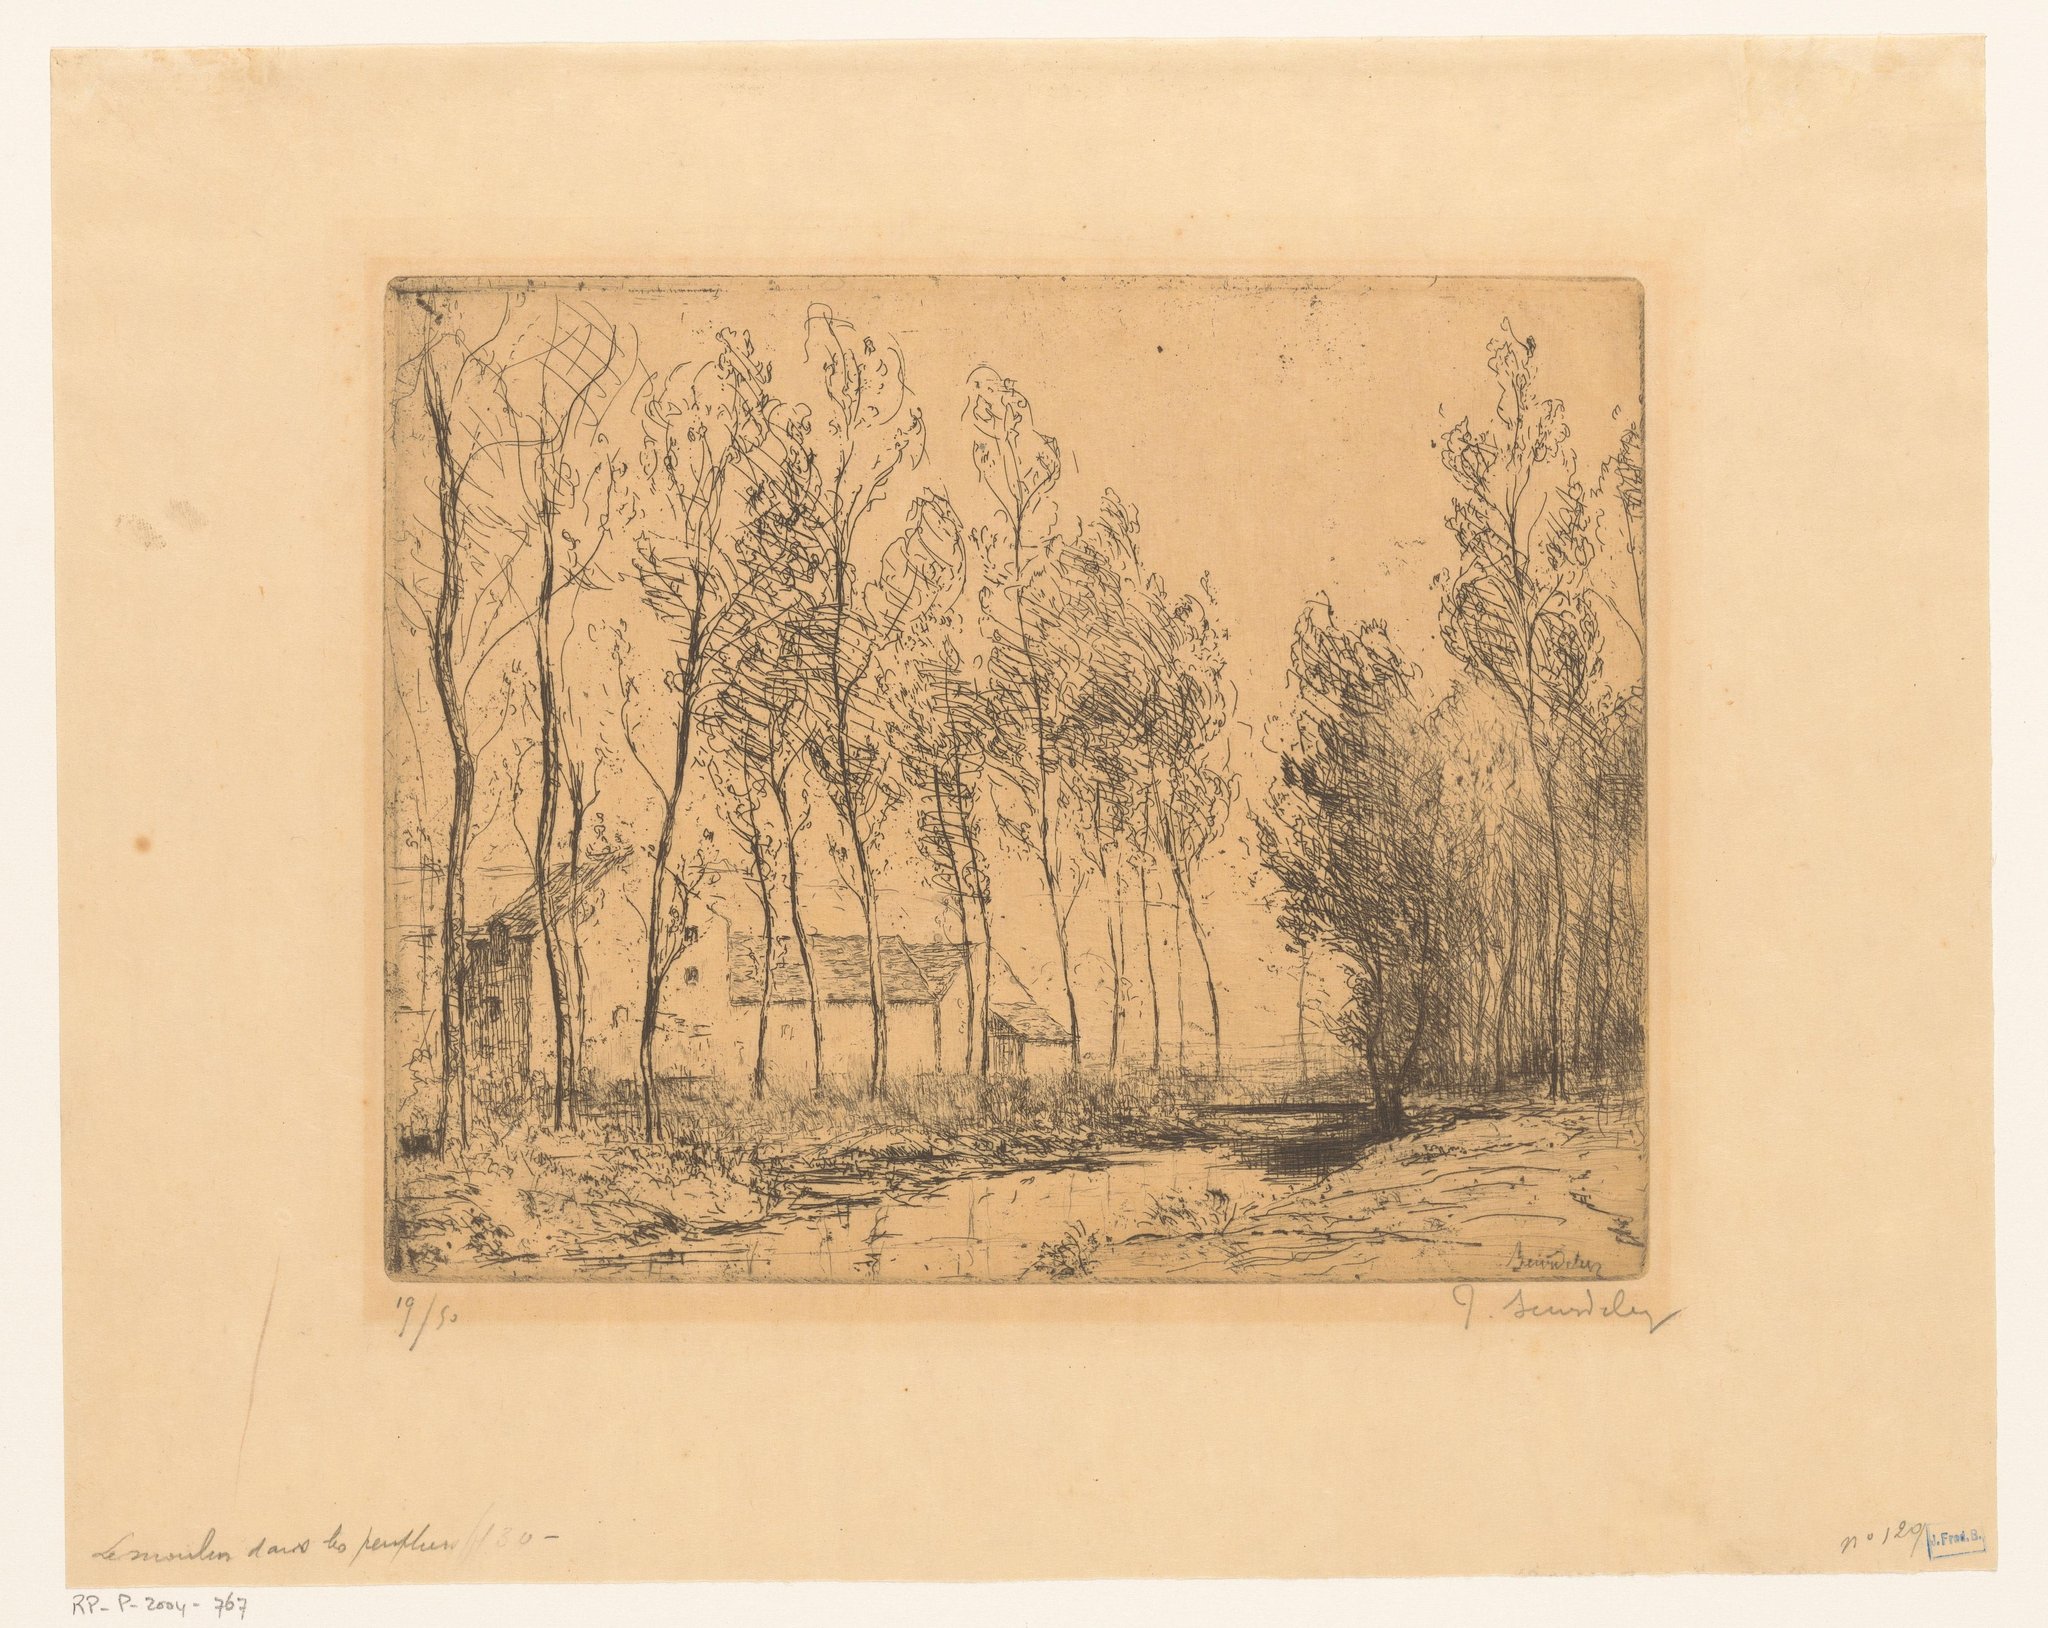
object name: print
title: Le moulin dans les peupliers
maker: jacques beurdeley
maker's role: print maker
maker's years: 1874-1954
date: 1912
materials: paper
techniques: drypoint, etching, intaglio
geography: france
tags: trees: poplar, forest, wood, watermill in landscape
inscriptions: collector's mark: Lugt 2228, collector's mark: Lugt 3761